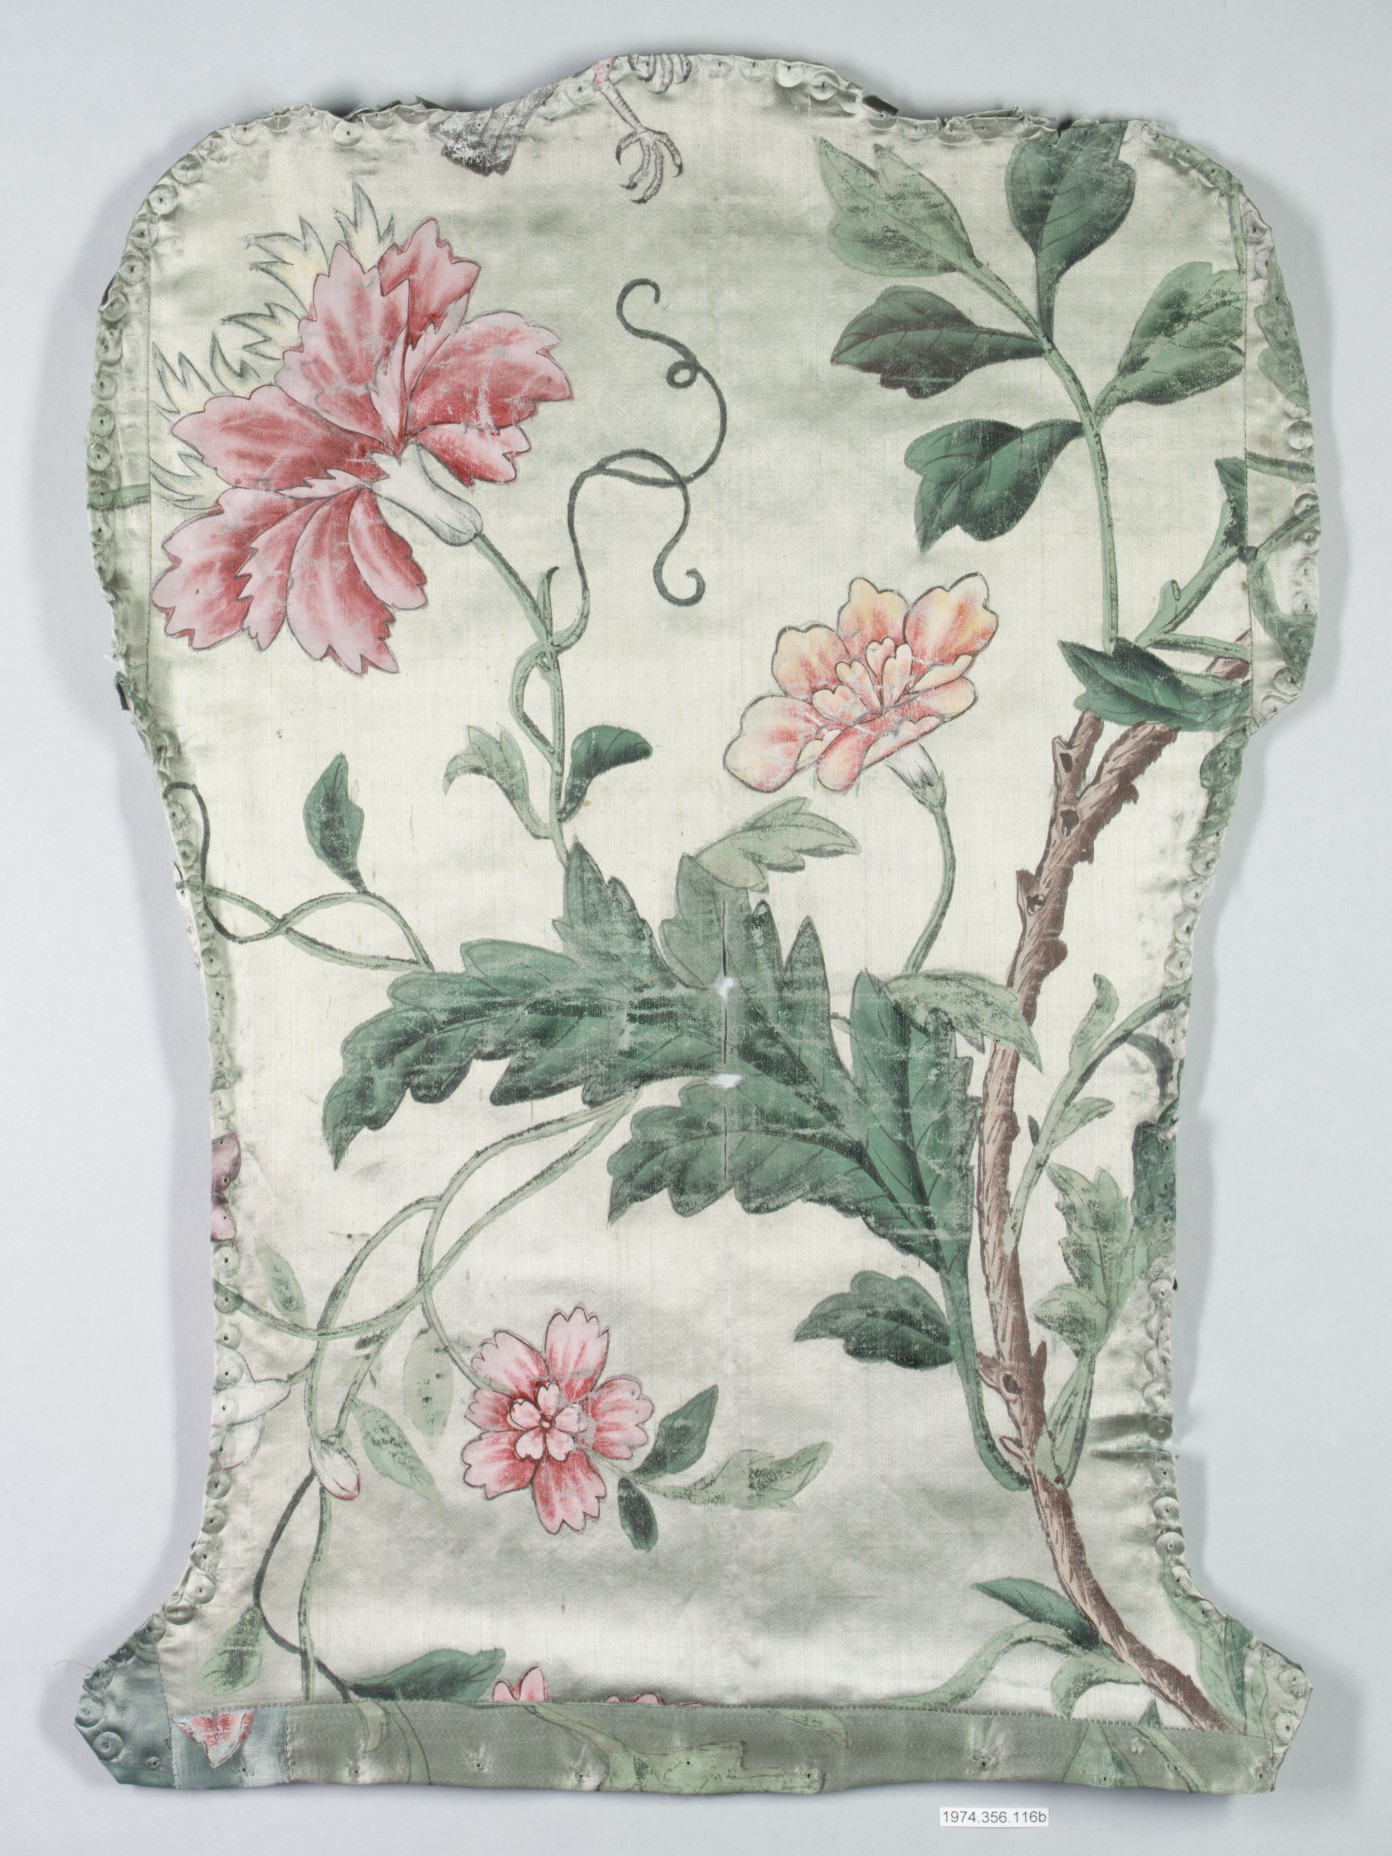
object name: upholstery panel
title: Upholstery panels for a side chair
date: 1763-1764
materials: silk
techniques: painting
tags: flowers